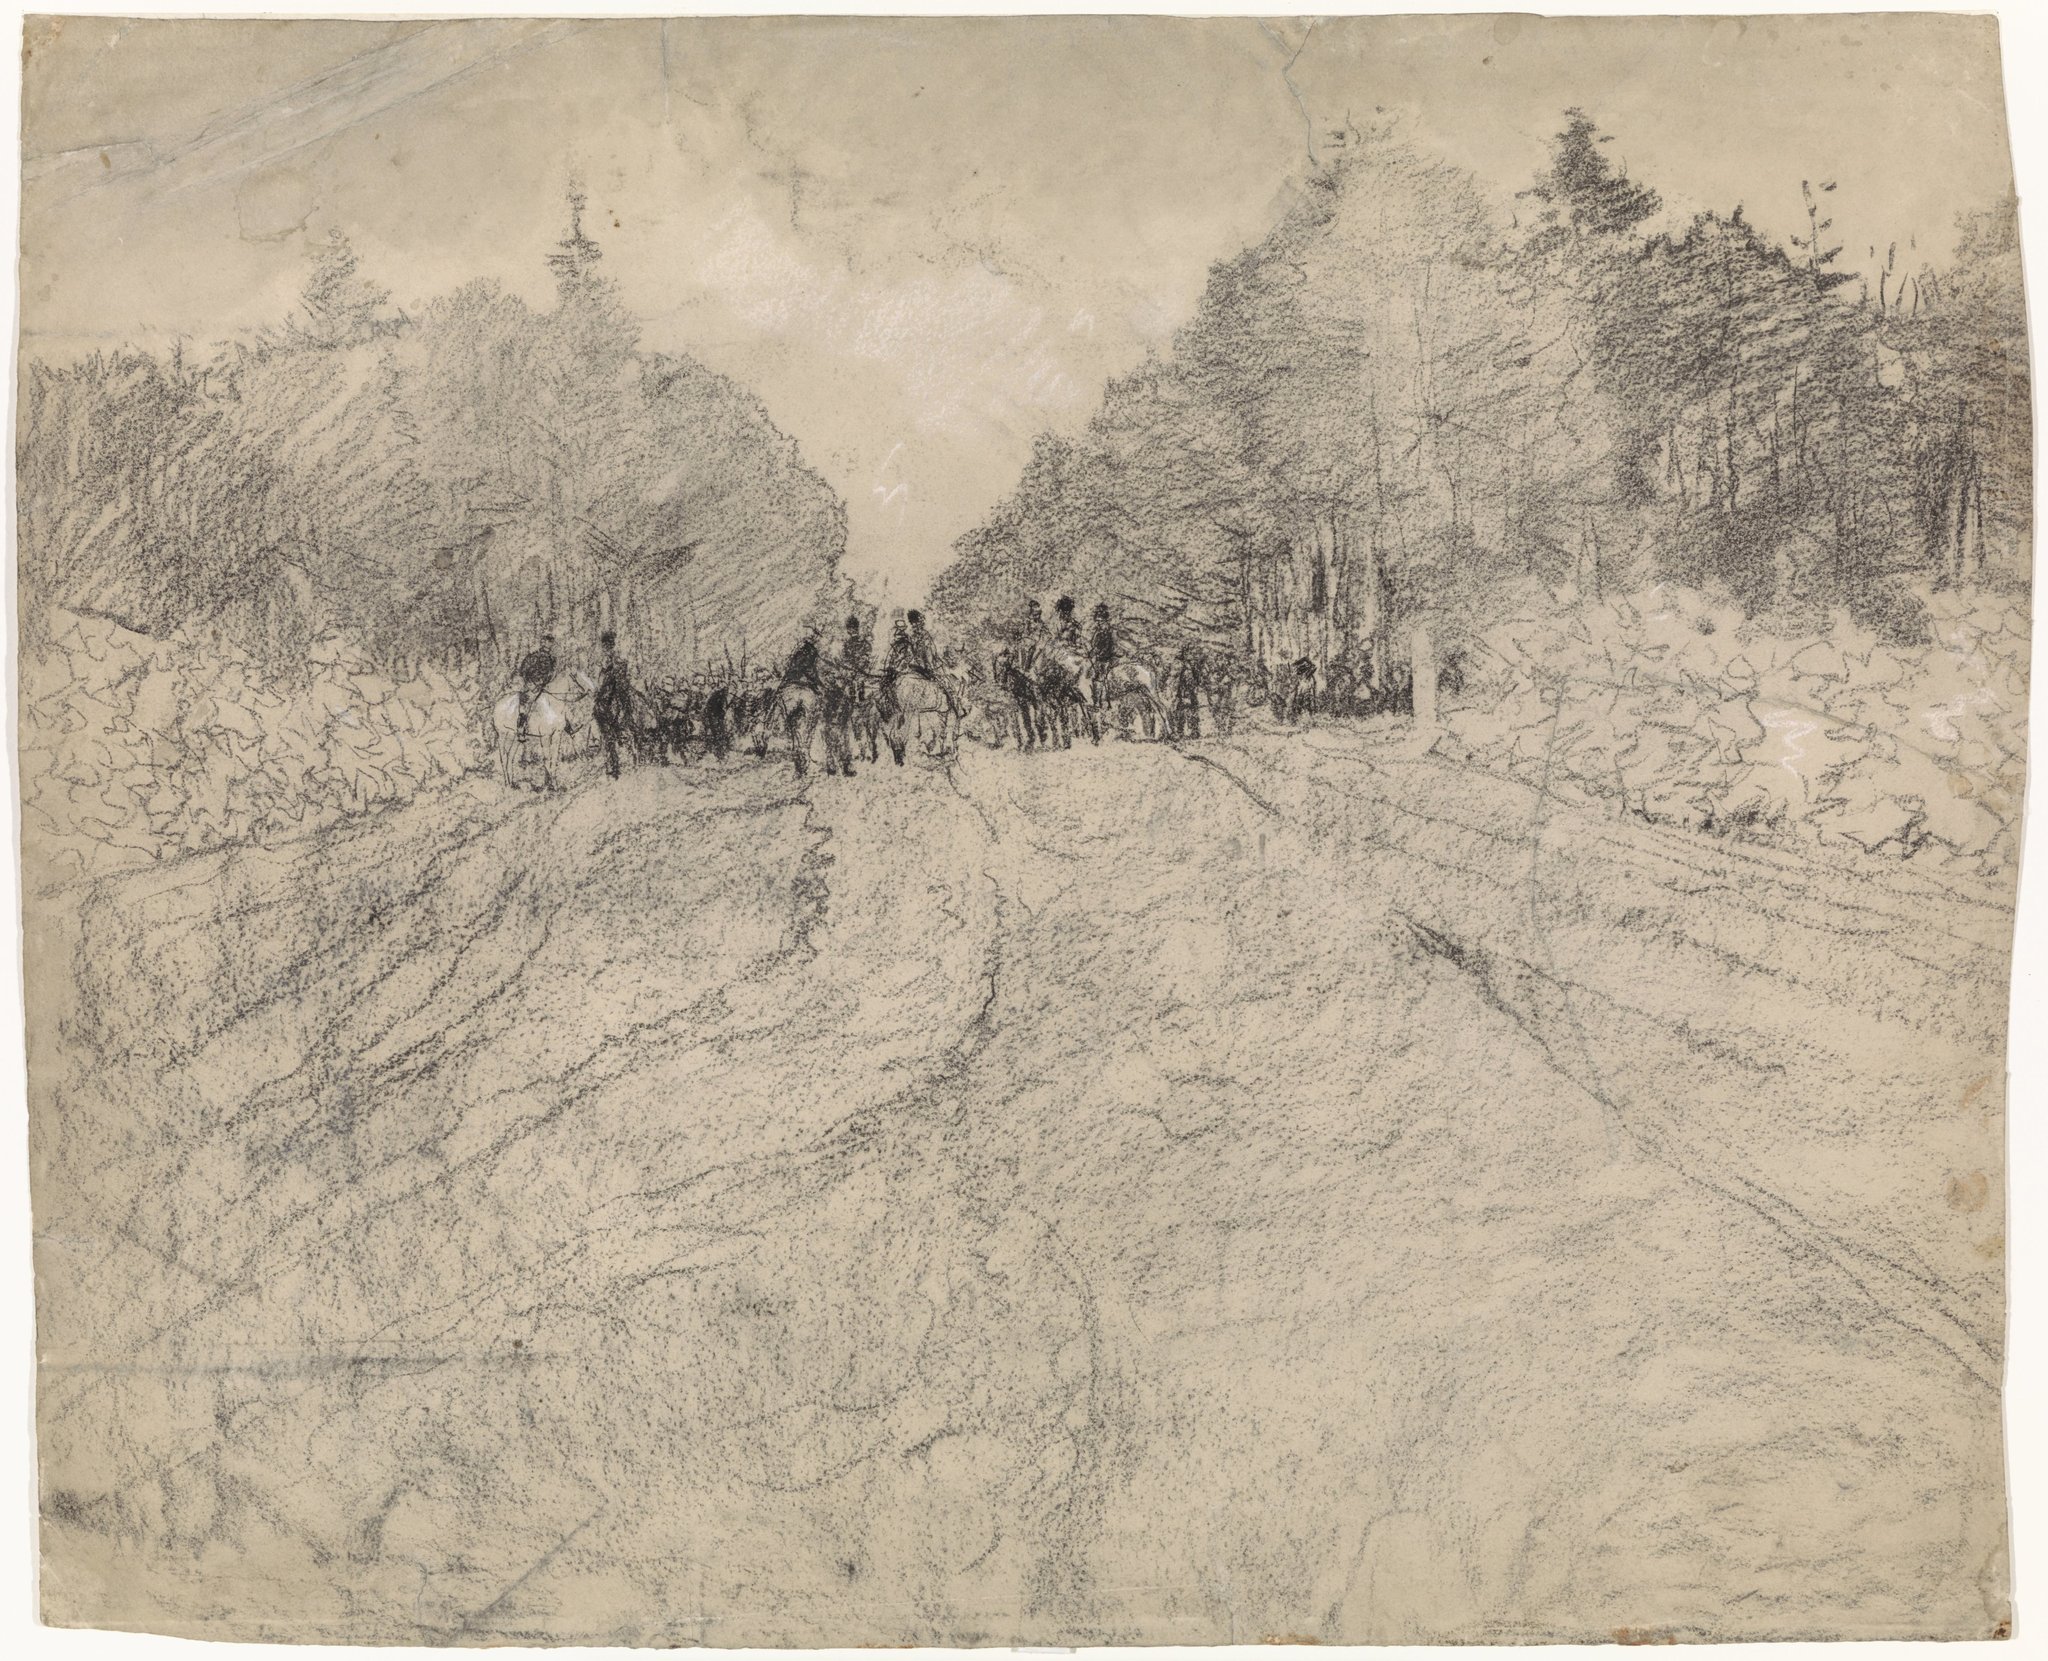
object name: drawing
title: Groep ruiters, zich verzamelend op breed bospad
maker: george hendrik breitner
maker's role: draughtsman, painter, print maker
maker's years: 1857-1923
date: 1867-1923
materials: chalk, paper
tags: forest, wood